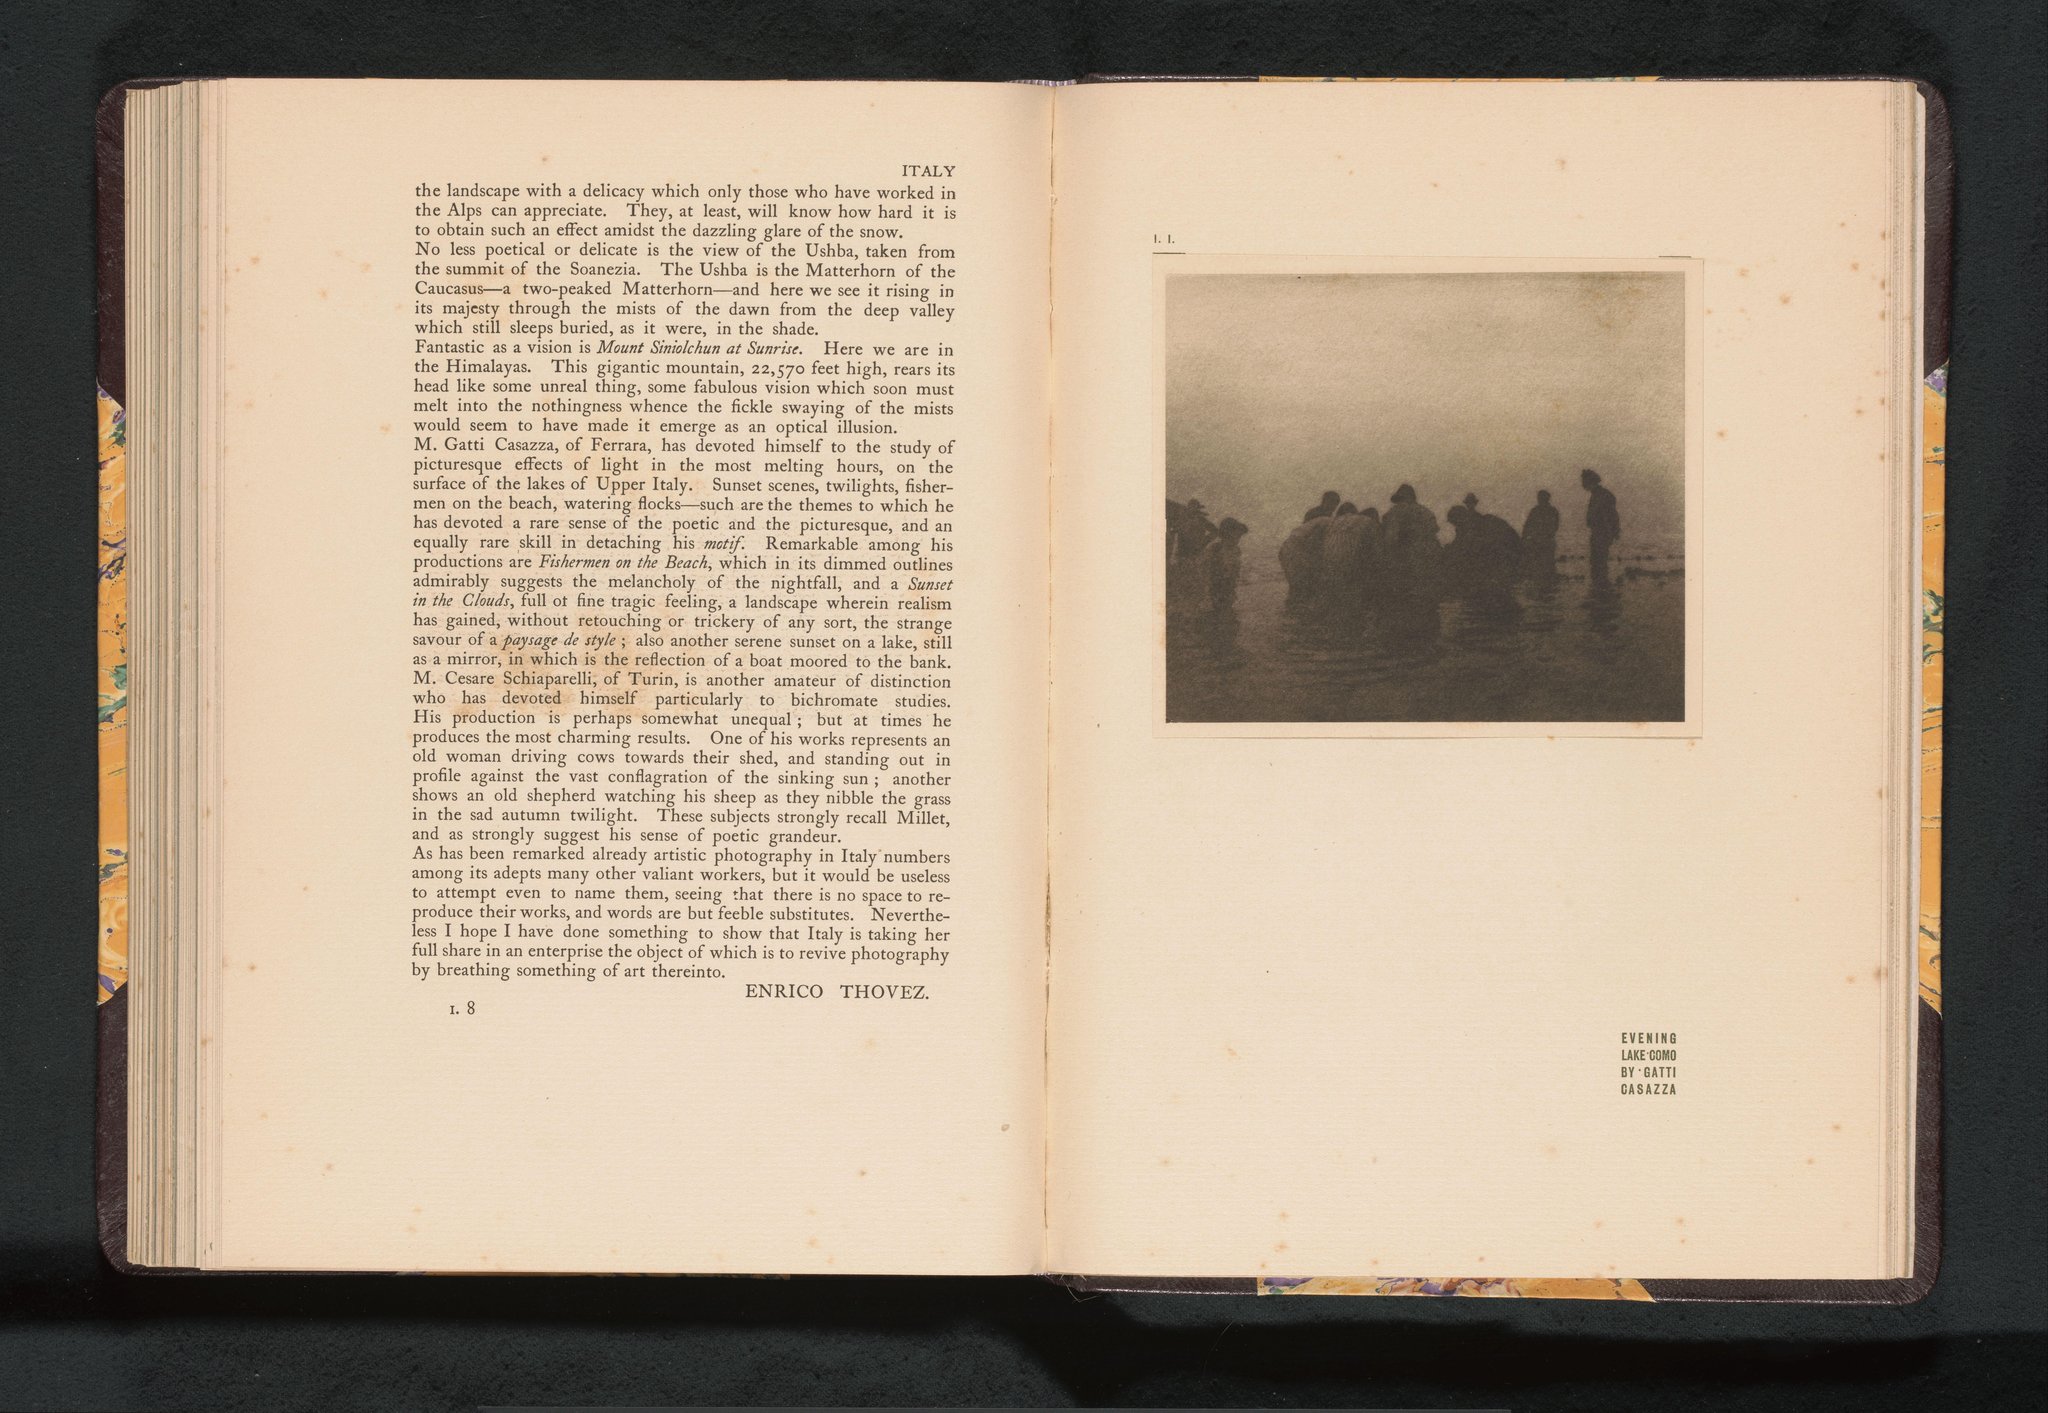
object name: page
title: Onbekend gezelschap in het Comomeer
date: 1900-1905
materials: paper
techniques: photoaquatint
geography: lake como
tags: lake (+ landscape with figures, staffage)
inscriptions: inscription: ‘Evening lake Como by Gatti Casazza’, inscription: ‘I. I.’